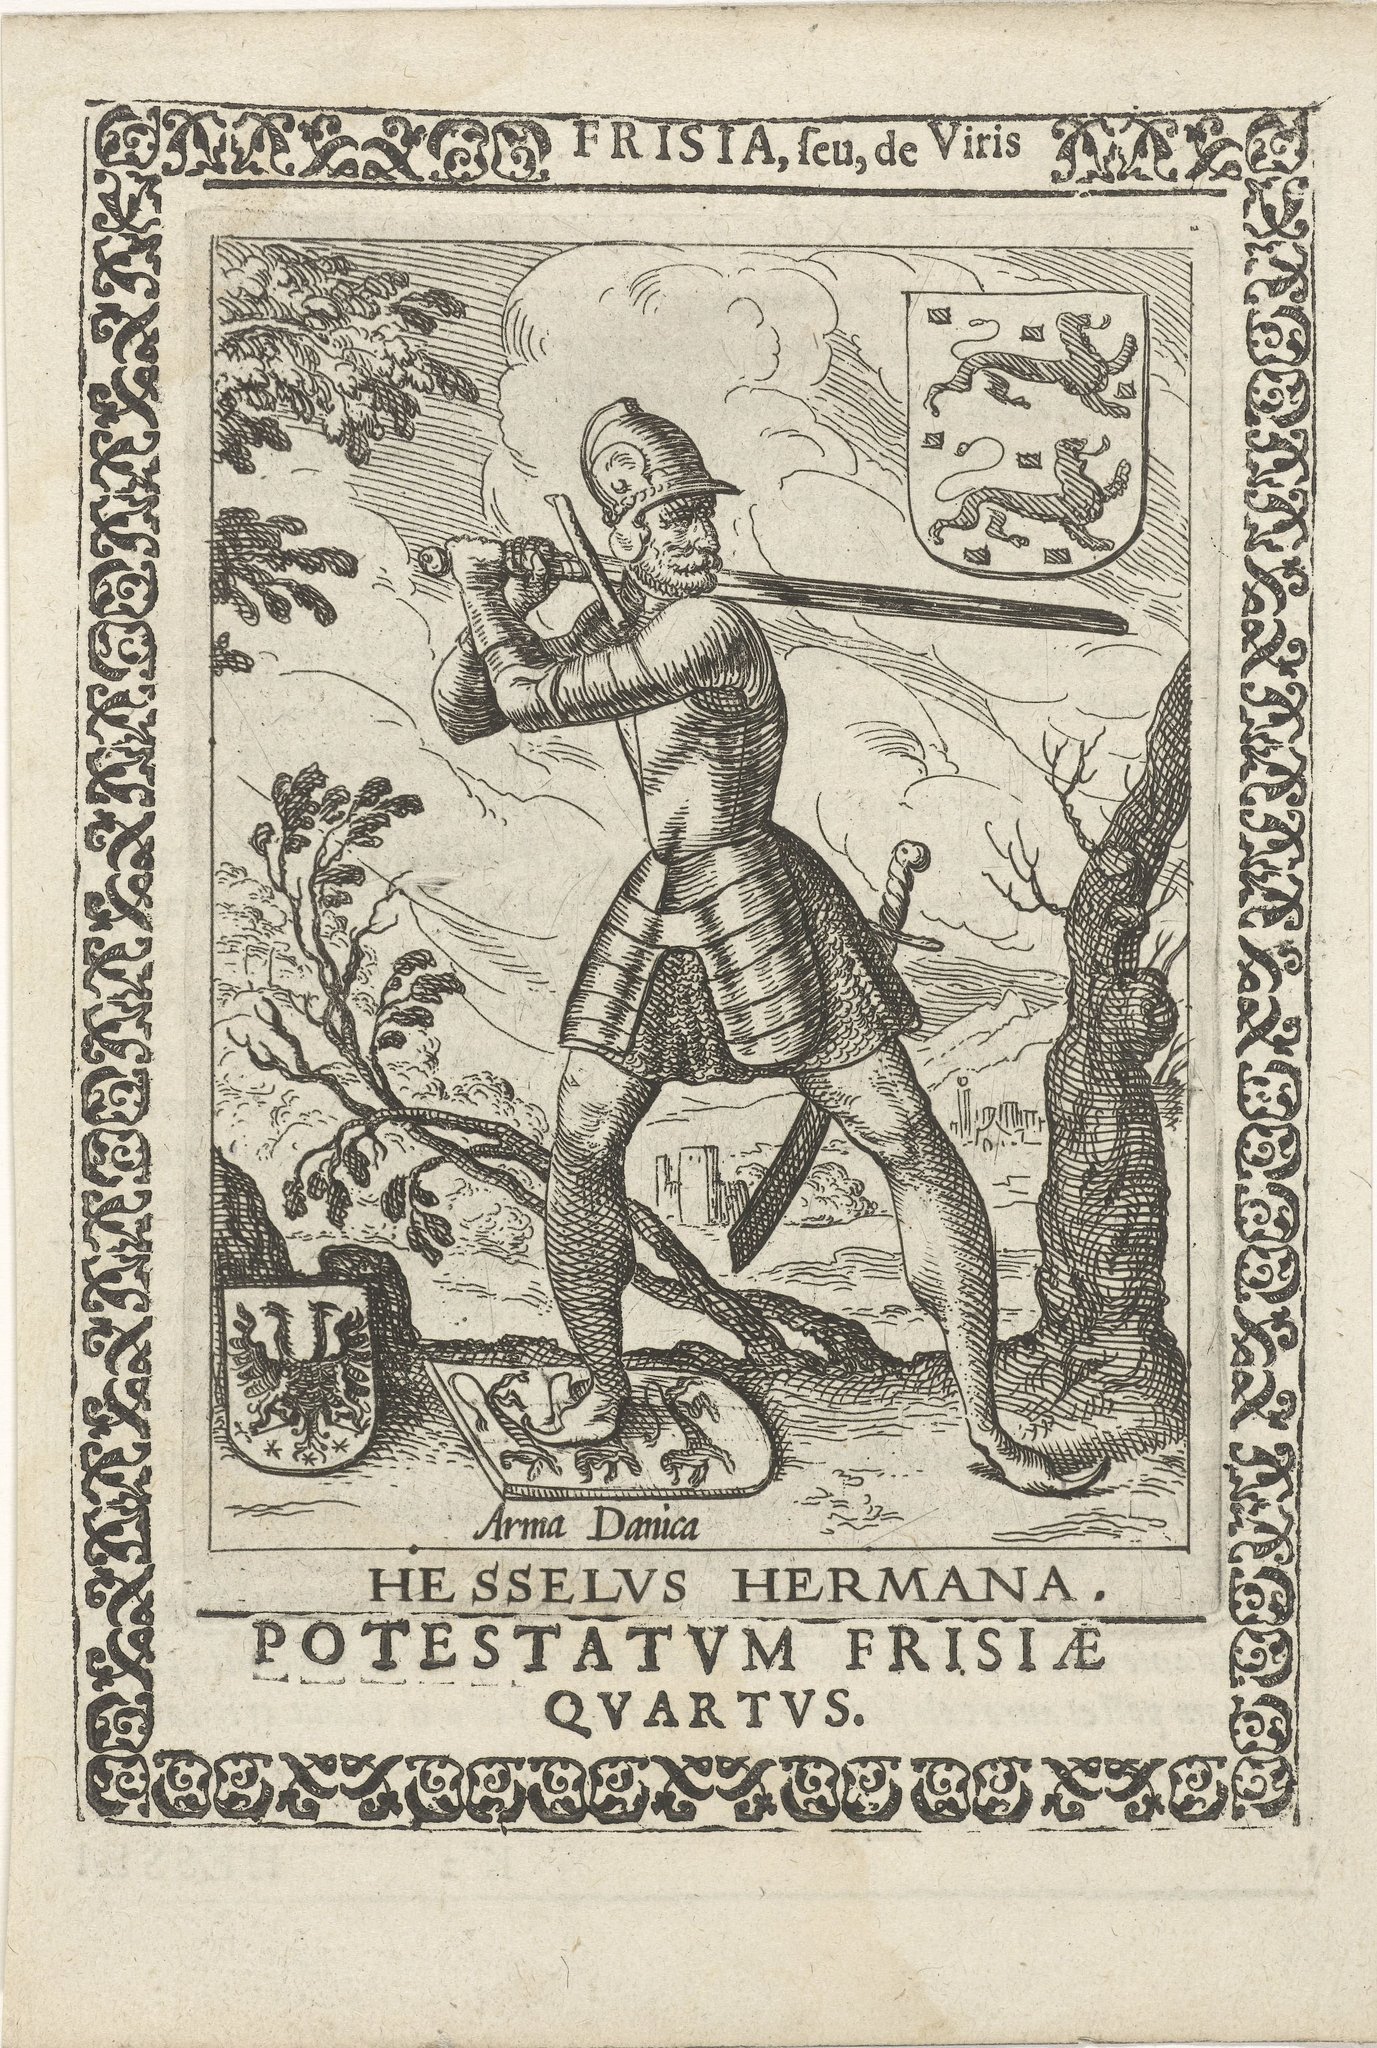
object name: book illustration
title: Hessel Hermana, vierde potestaat van Friesland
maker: pieter feddes van harlingen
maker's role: painter, print maker, publisher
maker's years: 1586-1623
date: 1618-1620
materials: paper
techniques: etching, letterpress printing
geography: friesland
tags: ruler, sovereign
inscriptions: collector's mark: Lugt 2228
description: Hessel Hermana, vierde potestaat van Friesland. Staande ten voeten uit, zwaard boven de schouder, het wapen van Denemarken vertredend. In een ornamentale omlijsting. Illustratie, met tekst op achterzijde, afkomstig uit het boek: Frisia seu de viris rebusque Frisiae illustribus libri duo.